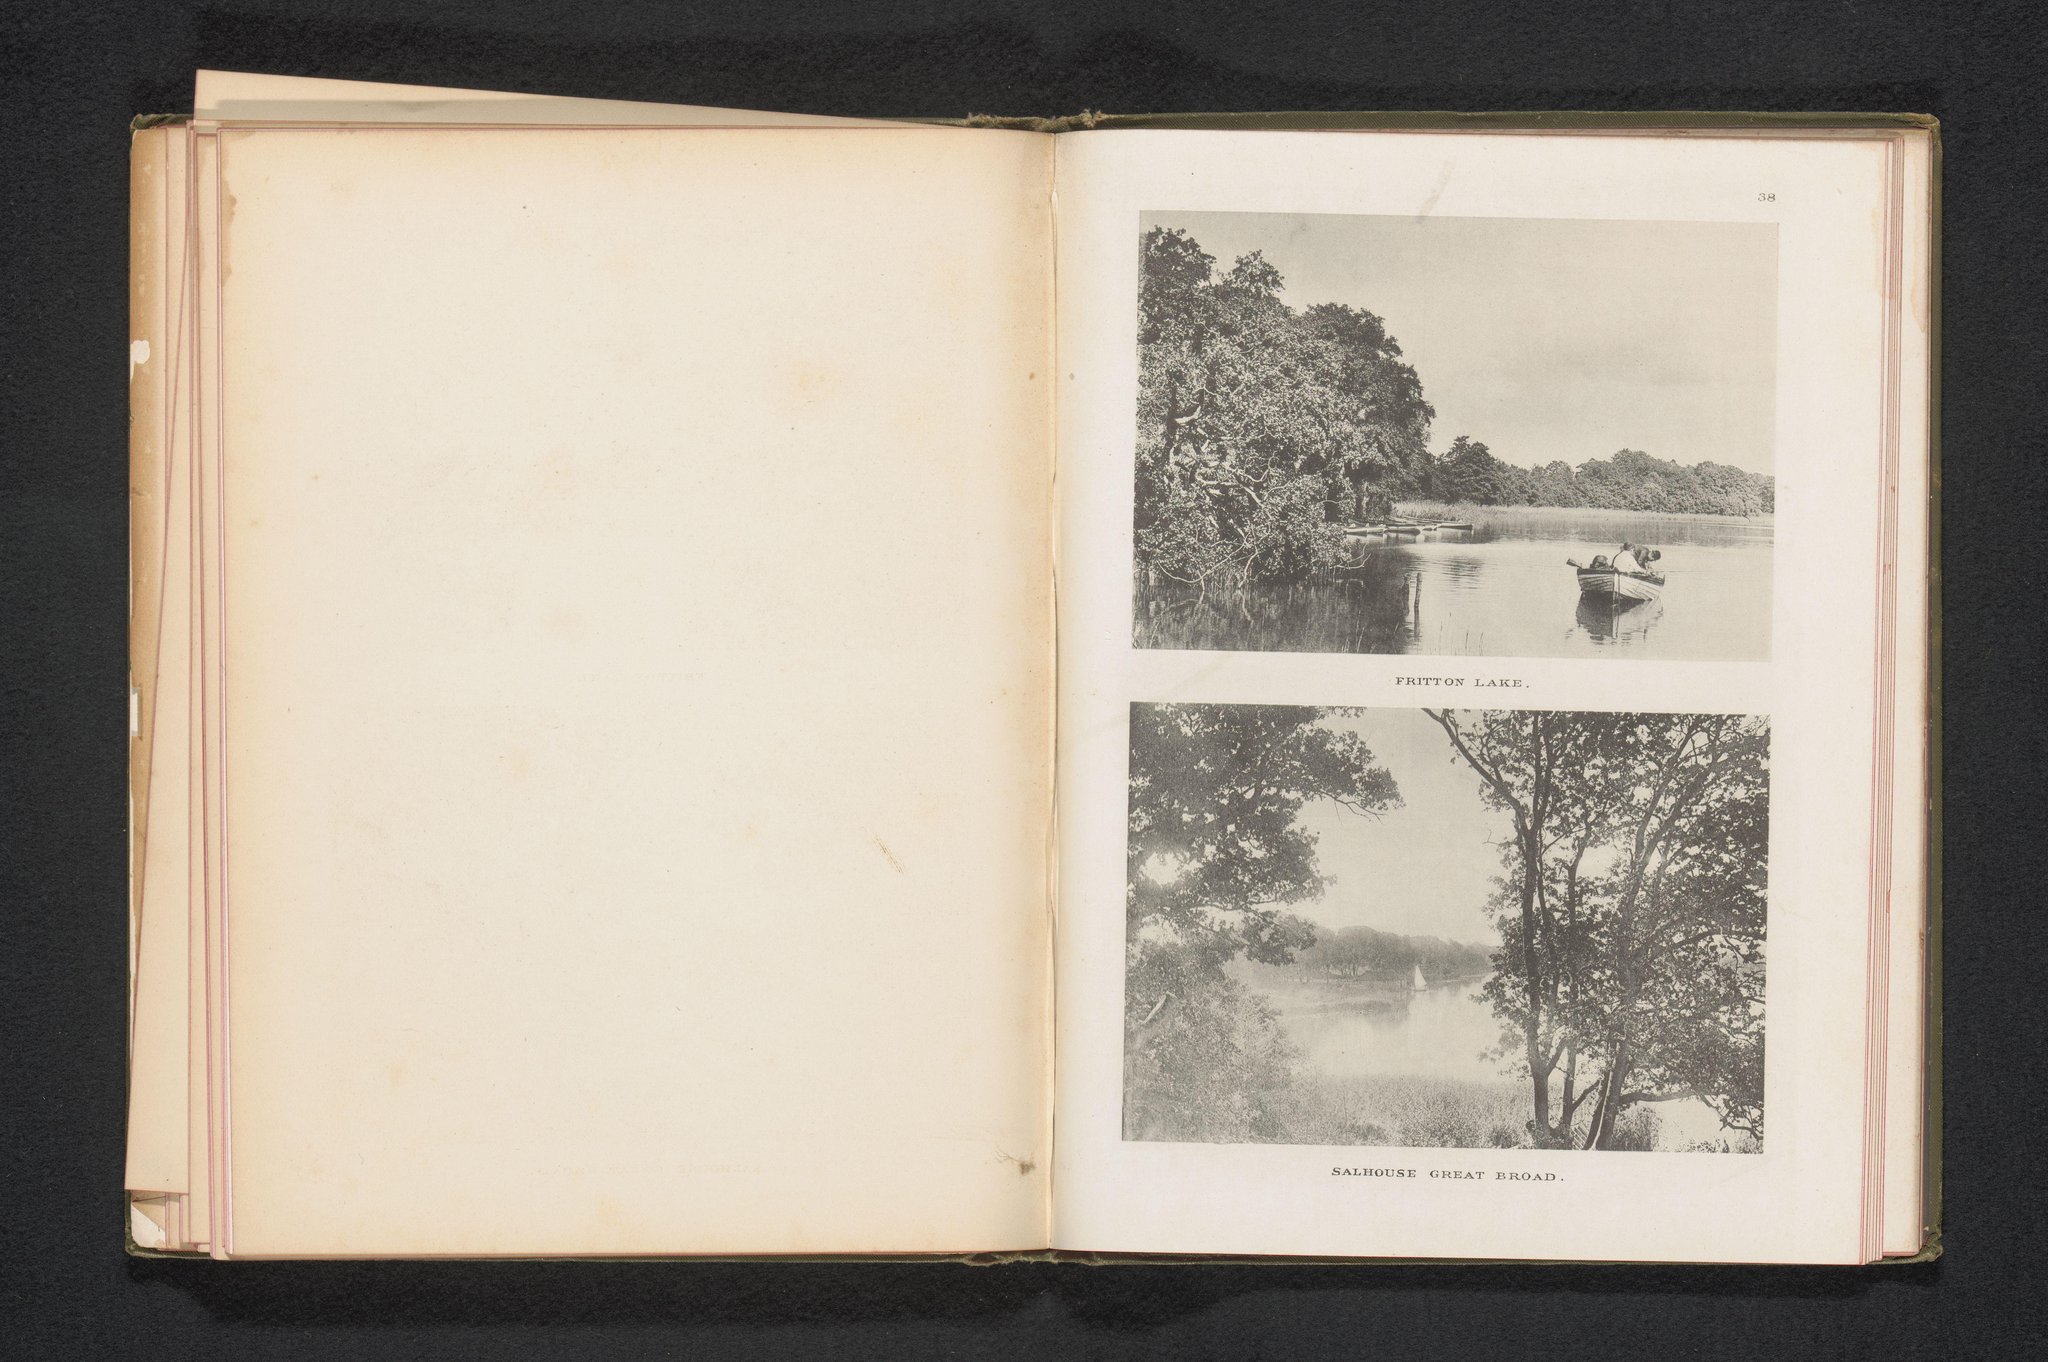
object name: page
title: Fritton Lake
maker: john payne jennings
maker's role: fotograaf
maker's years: 1843-1926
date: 1886-1891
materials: paper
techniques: photograph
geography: surrey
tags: rowing-boat, canoe, etc., lake